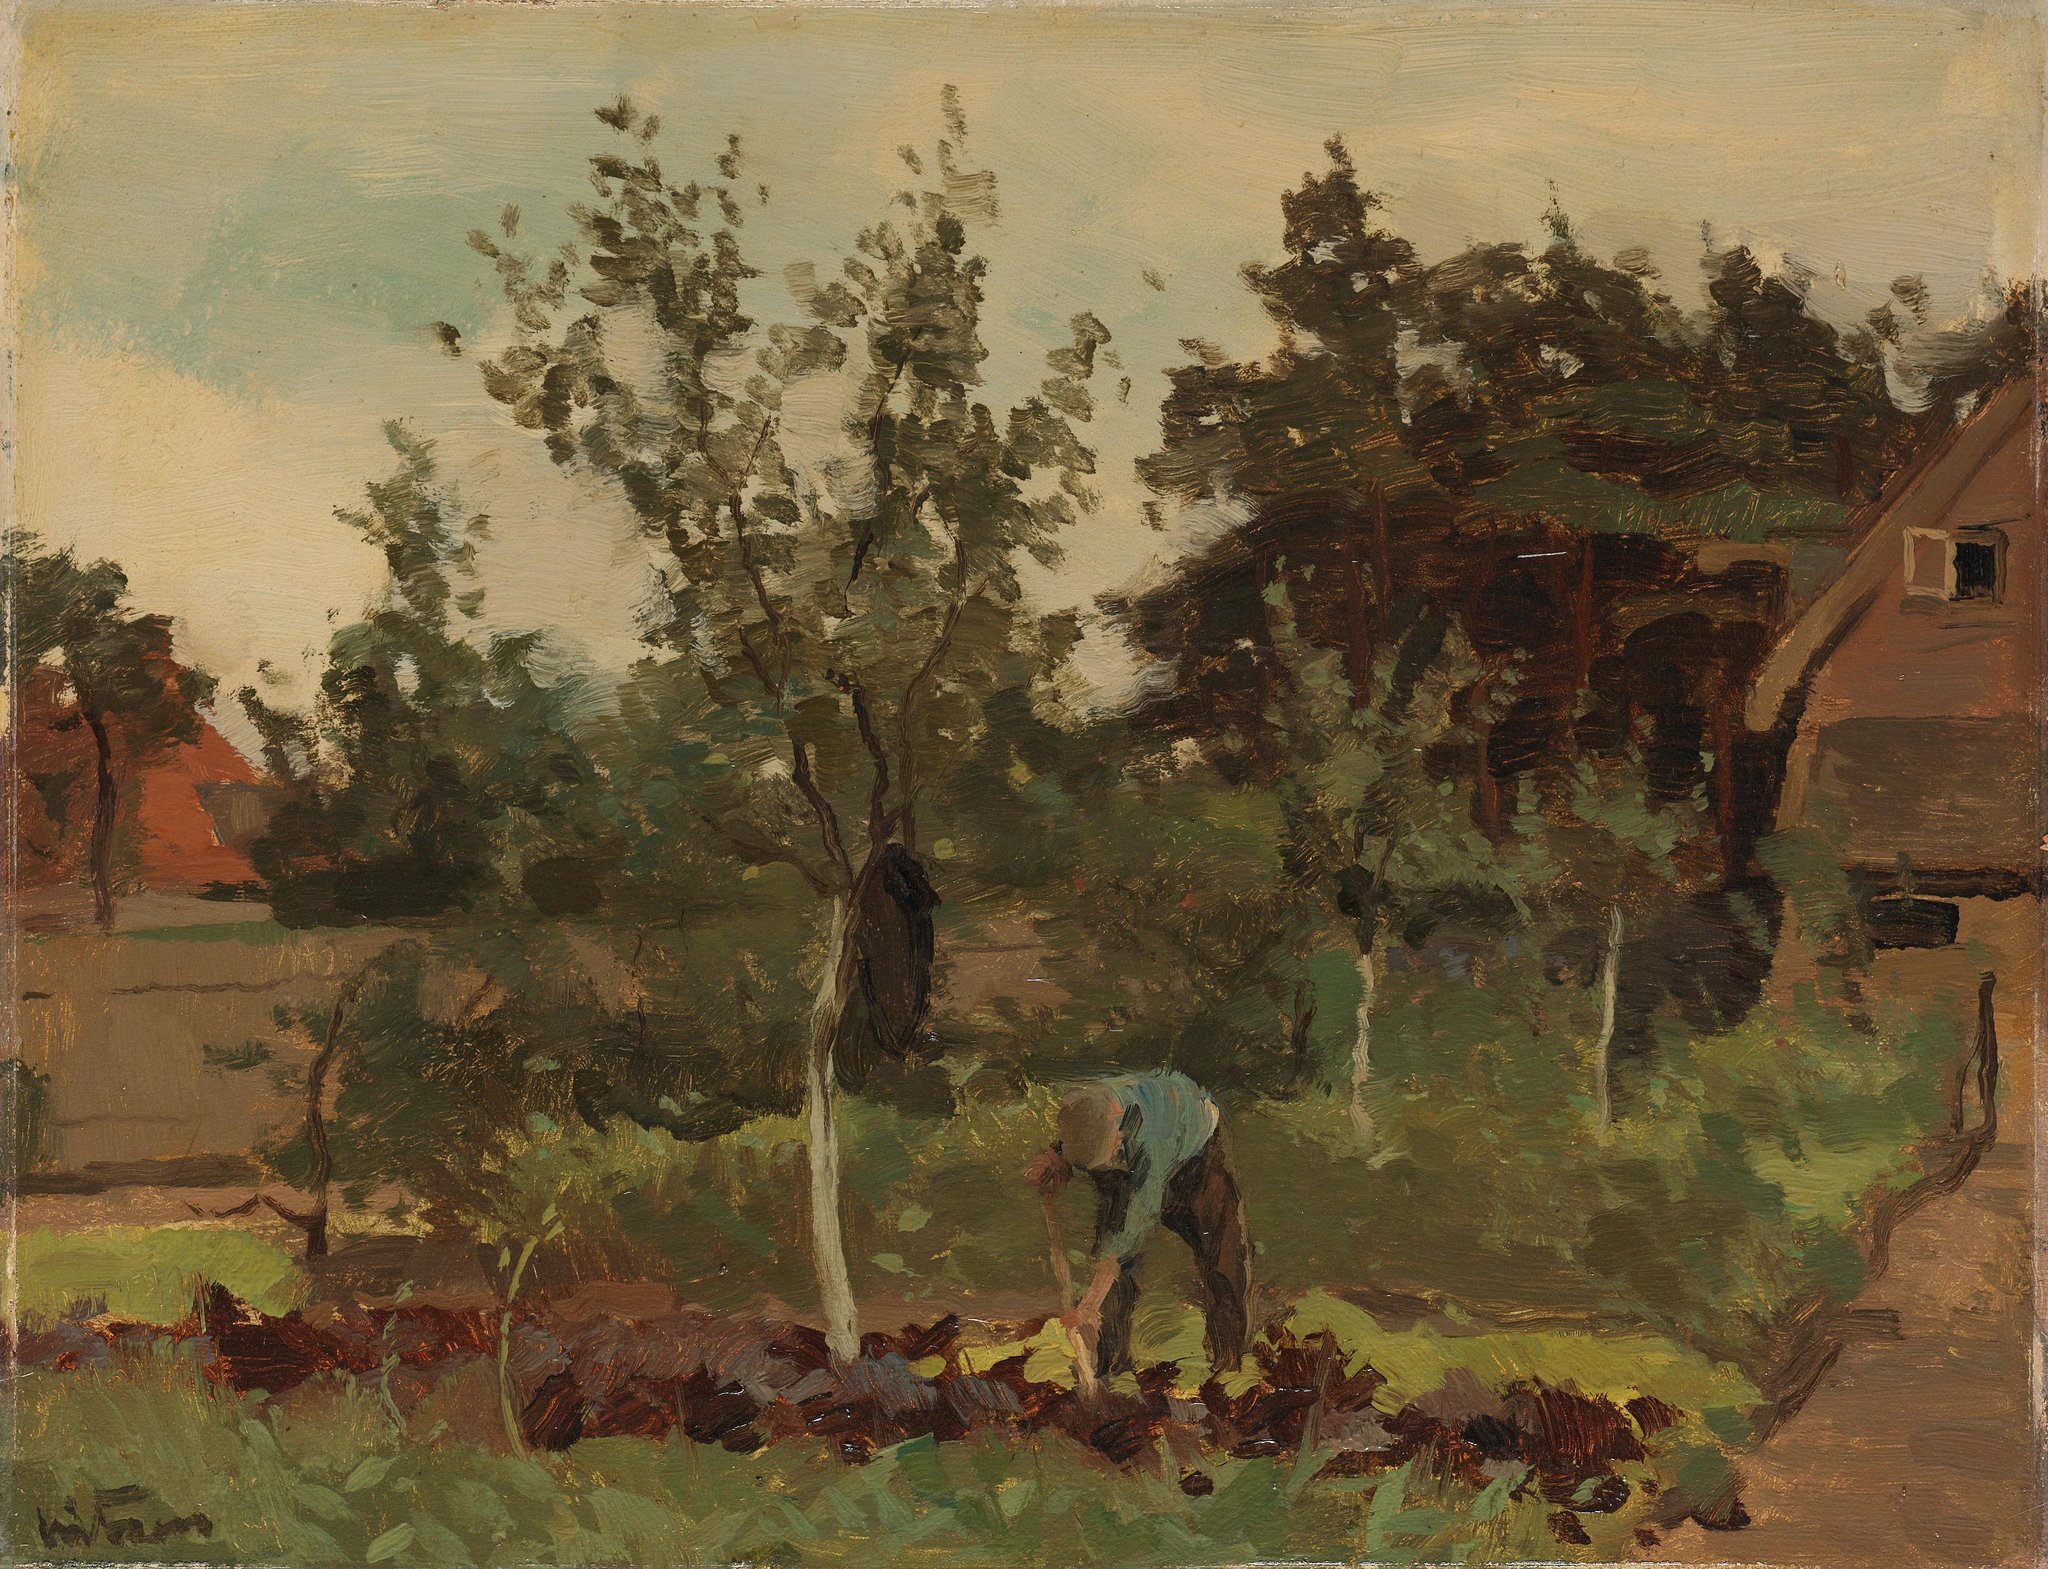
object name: painting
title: Moestuin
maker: willem witsen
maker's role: draughtsman, painter, print maker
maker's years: 1860-1923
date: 1885-1922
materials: oil, panel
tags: nursery, market garden, gardening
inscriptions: signature: ‘Witsen’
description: Een man staat voorovergebogen te werken in een moestuin. Rechts een huis met geboomte.